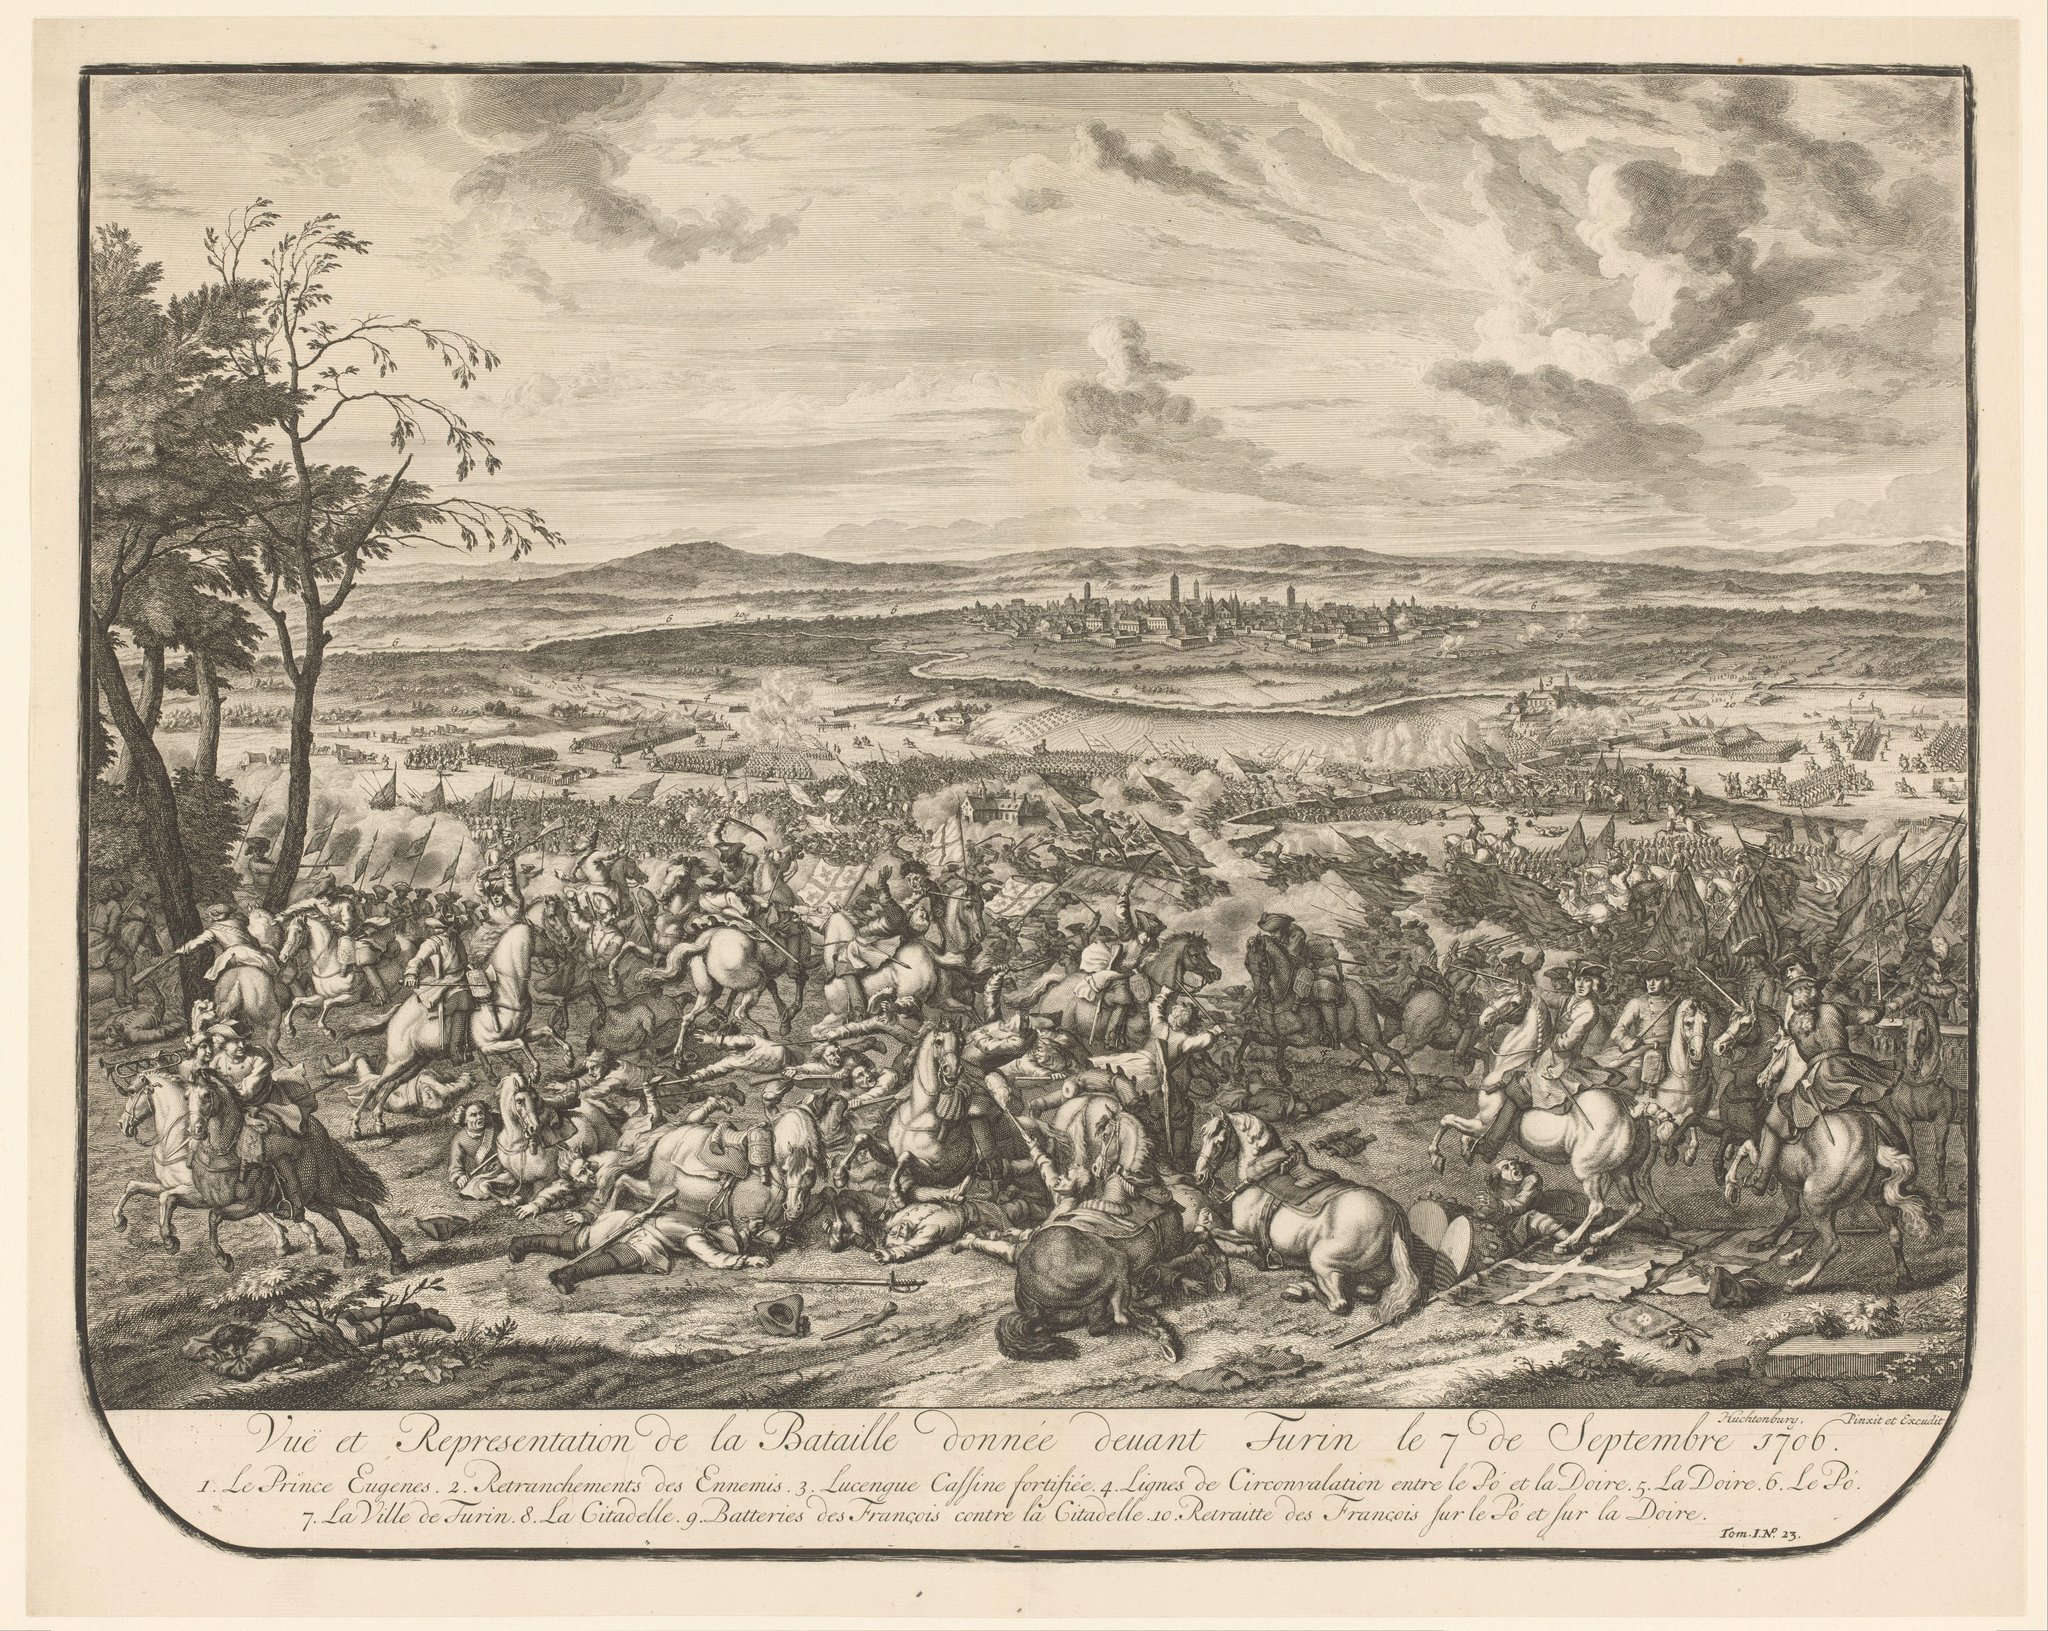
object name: print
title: Vuë et Representation de la Bataille donnée devant Turin le 7 de Septembre 1706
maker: jan van huchtenburg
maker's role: draughtsman, painter, print maker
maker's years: 1647-1733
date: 1727-1729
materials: paper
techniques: engraving, etching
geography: northern netherlands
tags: paris, vienna, eugenius van savoye, raising the siege with outside assistance, relief, battle (+ land forces)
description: In deze staat gebruikt als illustratie in het eerste deel van: Jean du Mont, Oorlogskundige beschryving van de veldslagen en belegeringen, der drie ... wydvermaarde krygsoversten... den Prins Eugenius van Savoye, den ... Hertog van Marlborough, en den Prins van Oranje en Nassau-Vriesland, in de editie van 1729.